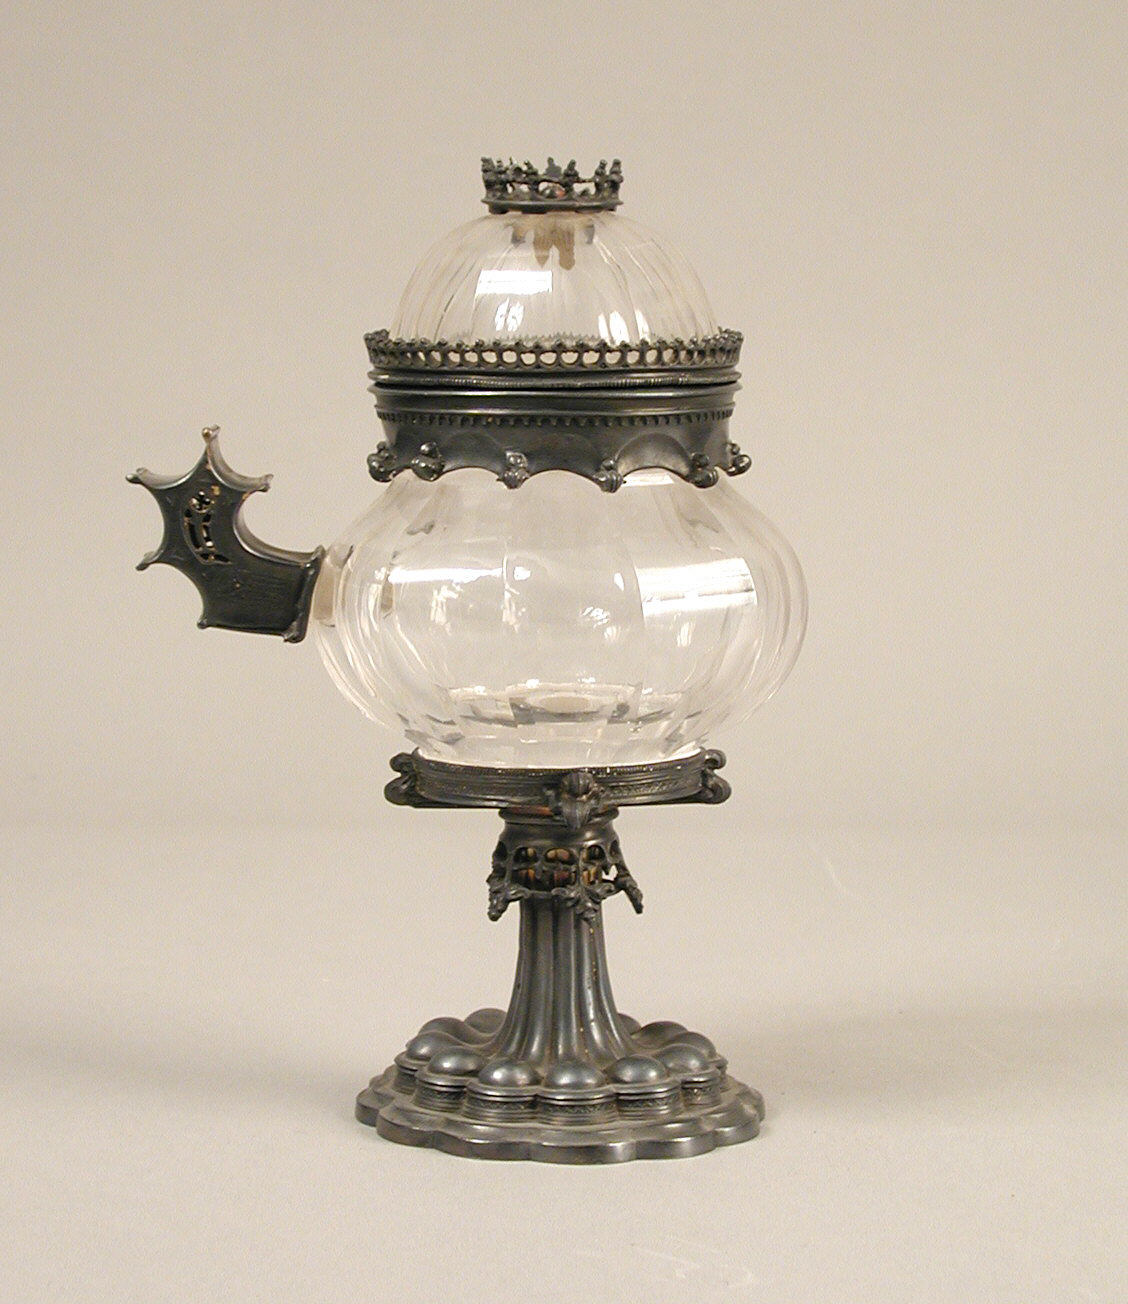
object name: cup with cover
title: Cup and Cover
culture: german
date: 1901-1933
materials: crystal, silver gilt